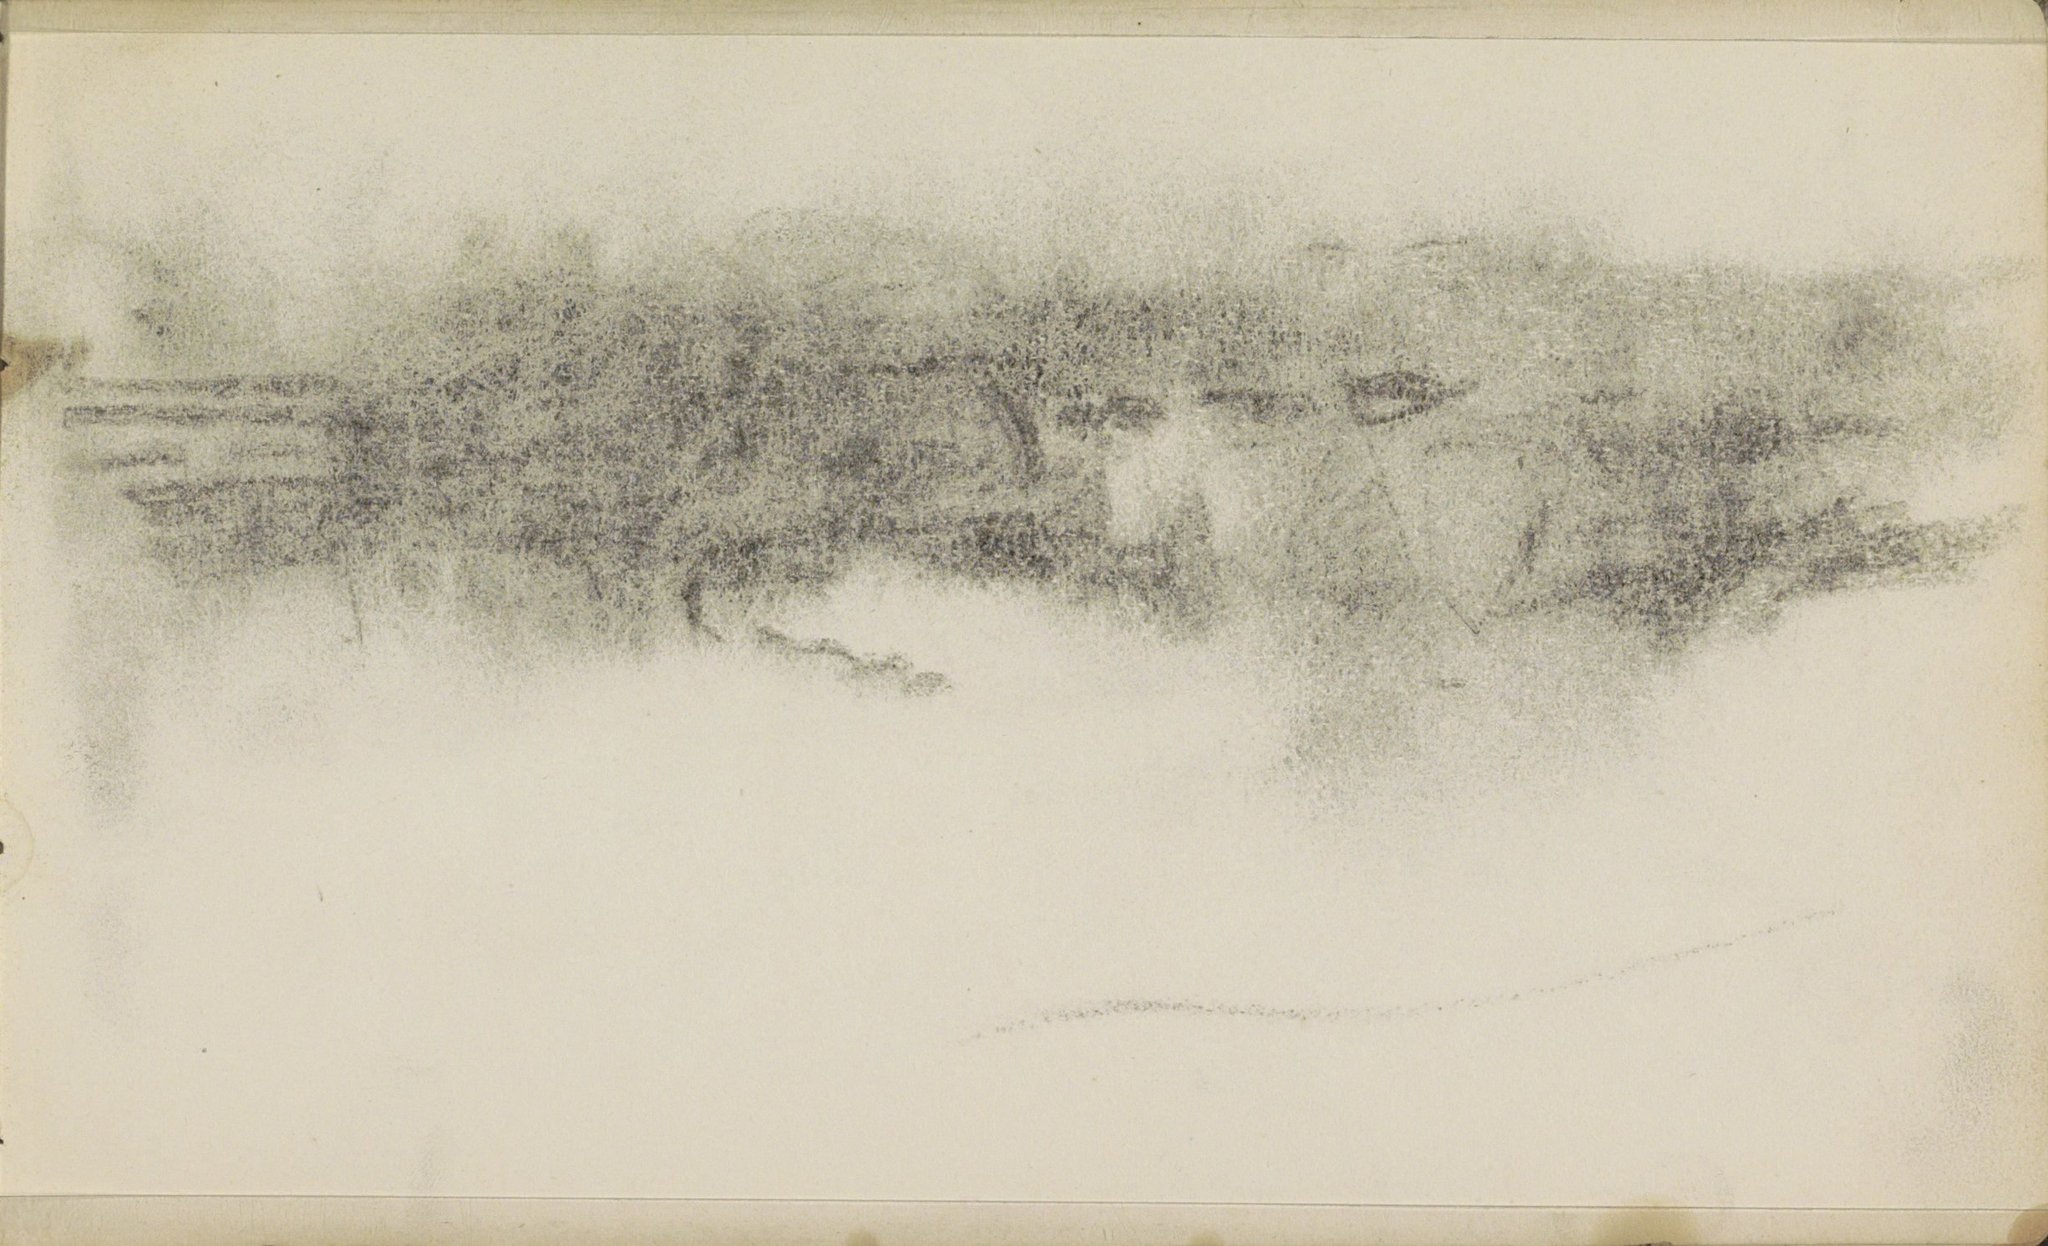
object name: sketchbook leaf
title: Landschap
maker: jozef israëls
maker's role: draughtsman, painter, print maker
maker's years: 1824-1911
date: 1834-1911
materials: chalk, paper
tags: landscapes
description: Blad 36 recto uit een schetsboek met 42 bladen.